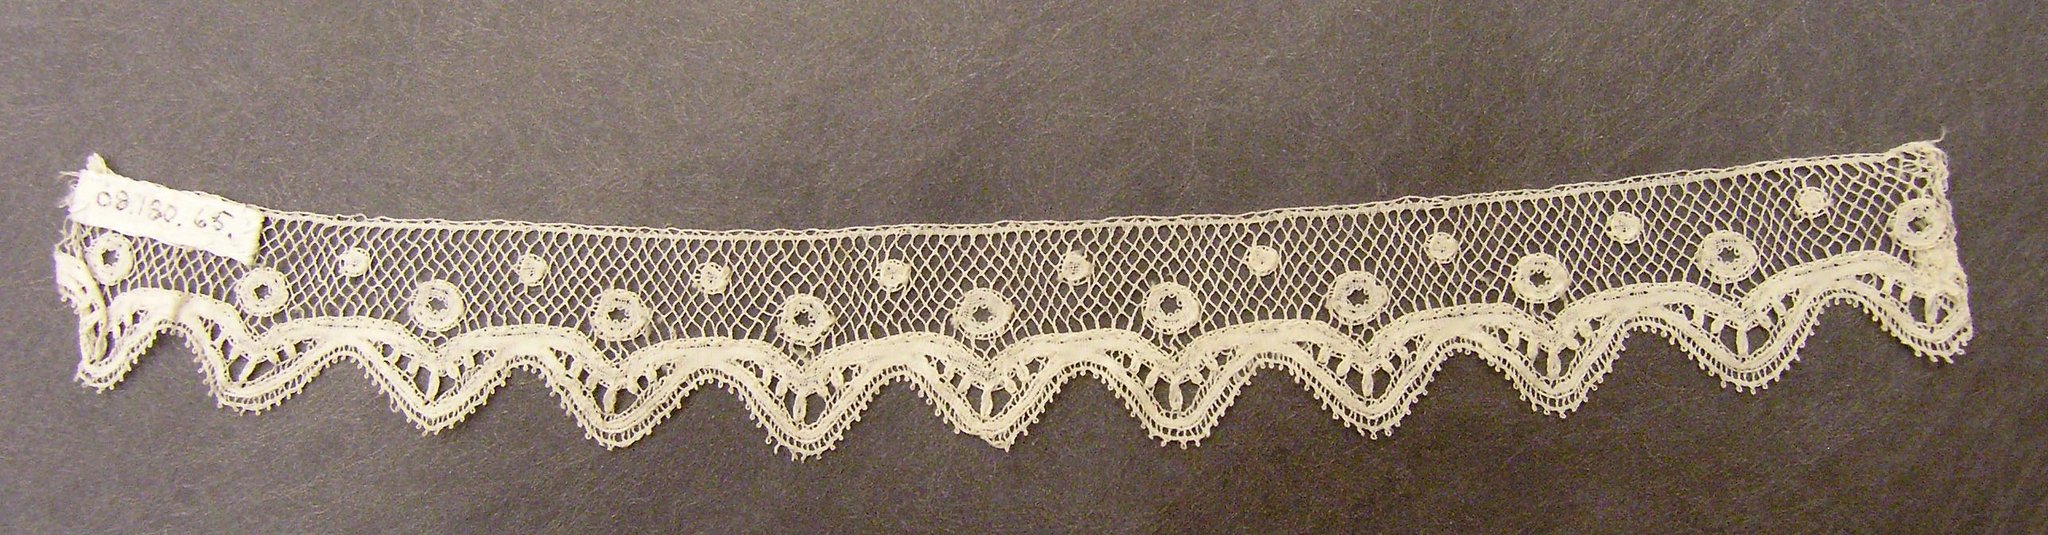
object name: fragment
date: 1801-1900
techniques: lace